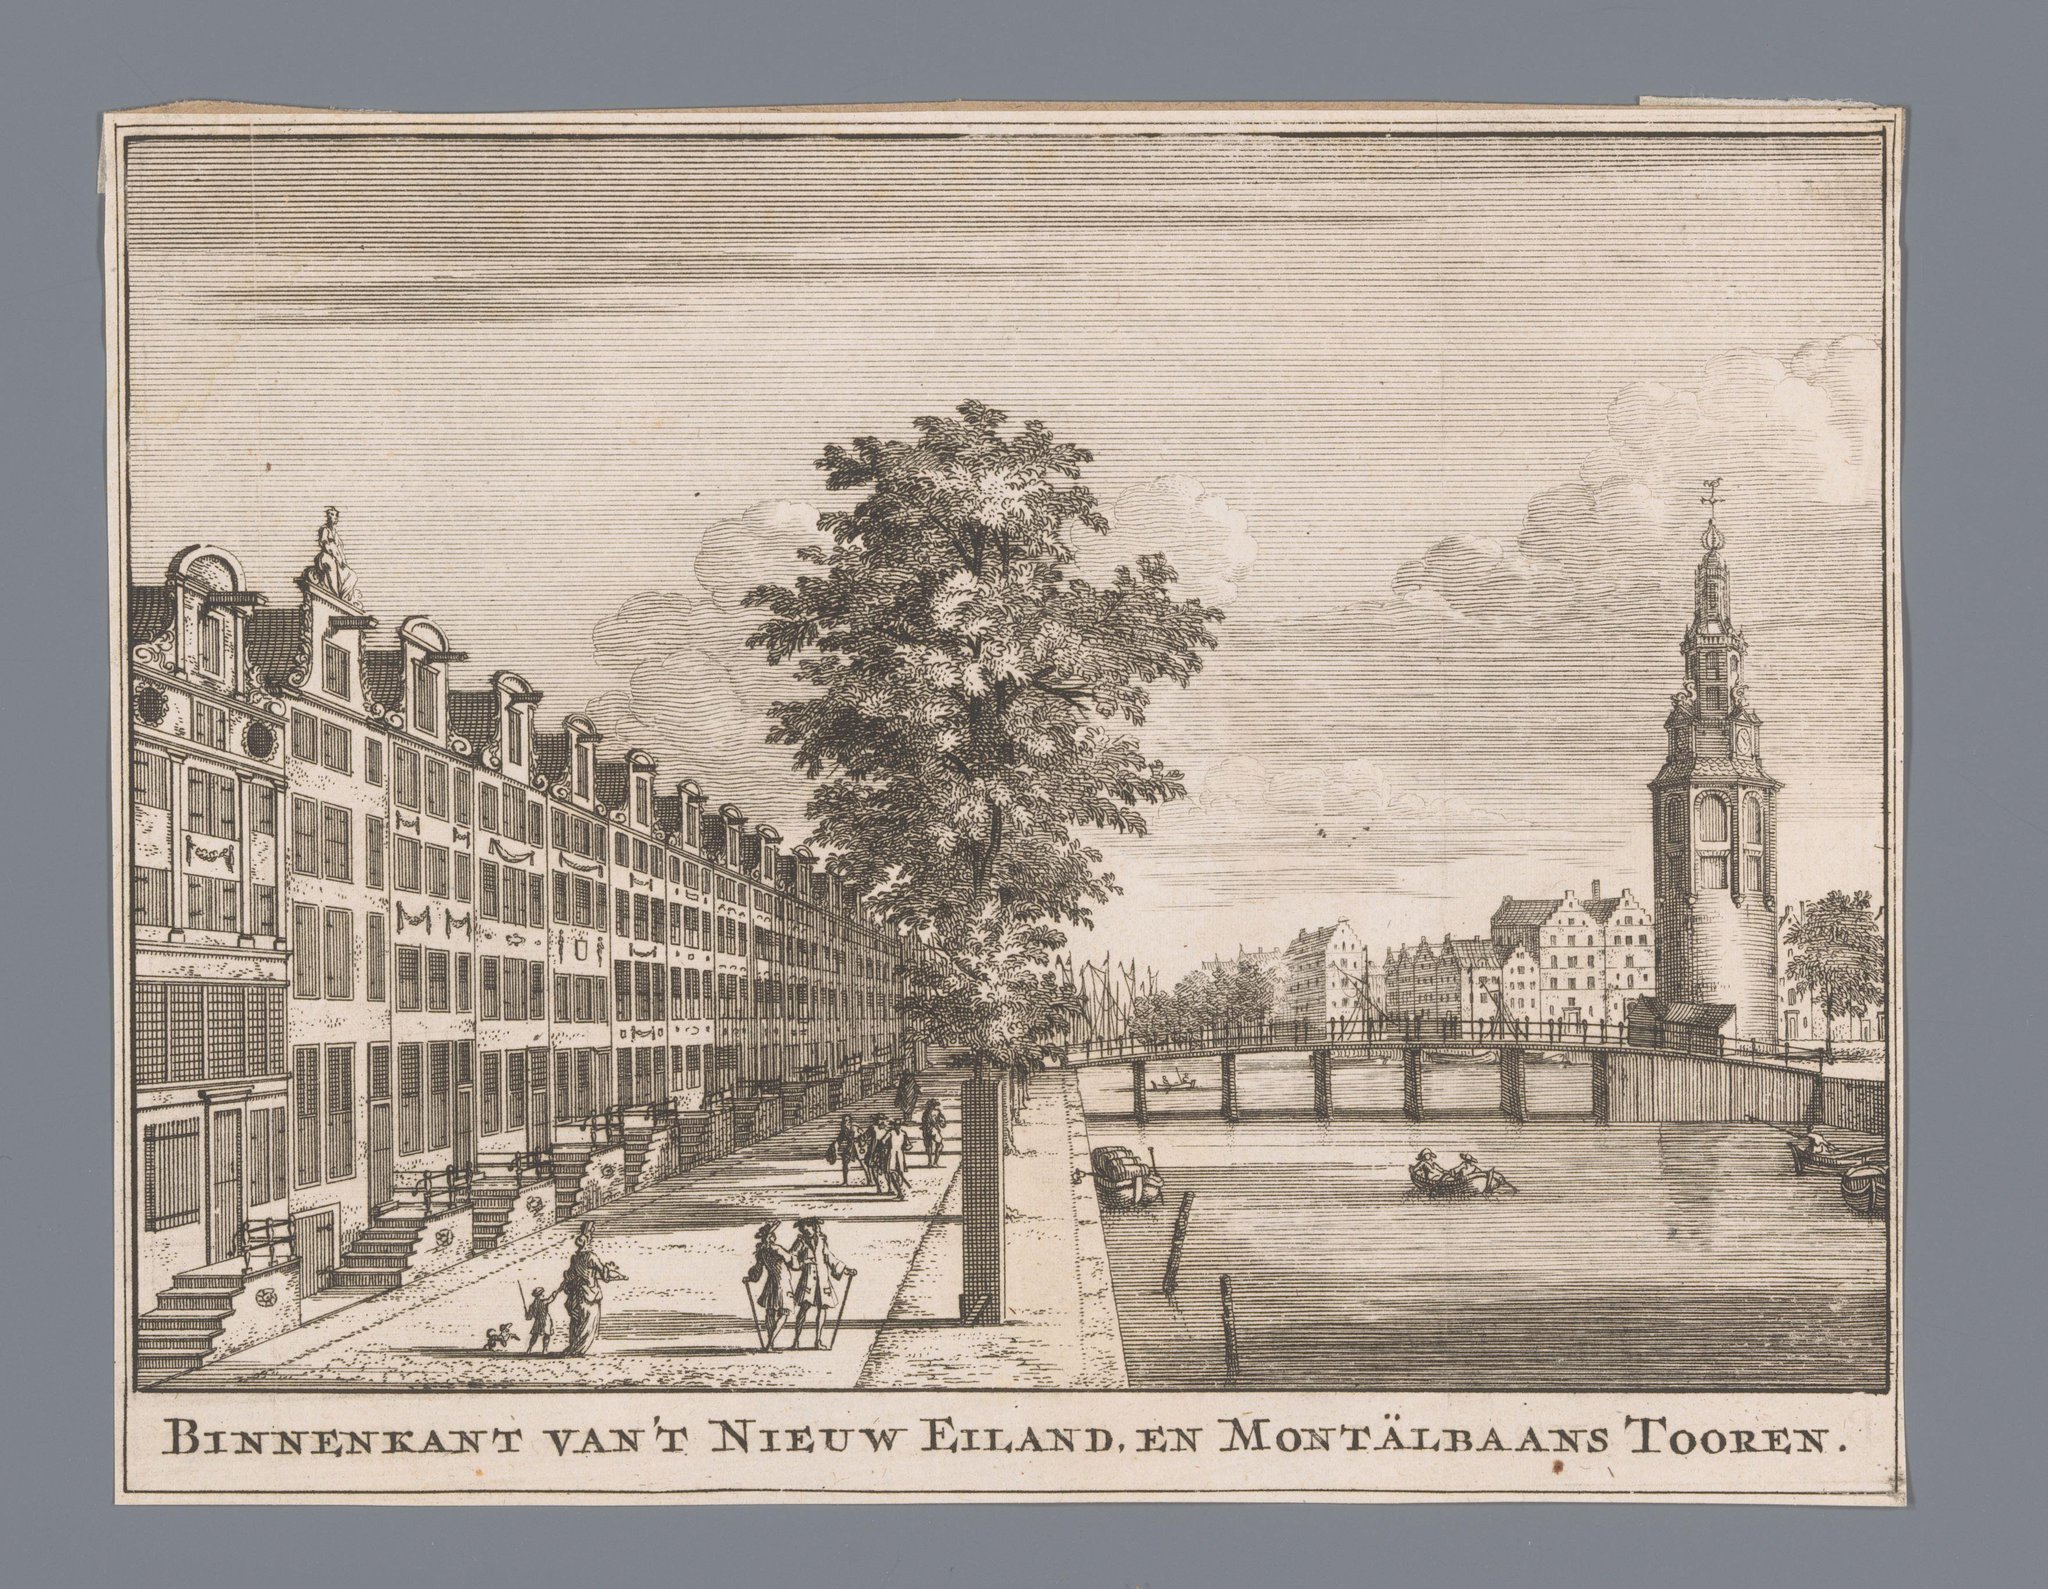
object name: print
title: Gezicht op de Binnenkant en de Montelbaanstoren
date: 1713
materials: paper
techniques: engraving, etching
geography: amsterdam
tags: urban housing, towers ~ fortified city, rowing-boat, canoe, etc., bridge in city across river, canal, etc.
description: Gezicht op de Binnenkant op het Waalseiland te Amsterdam, gezien richting de Oudeschans met rechts de Montelbaanstoren.